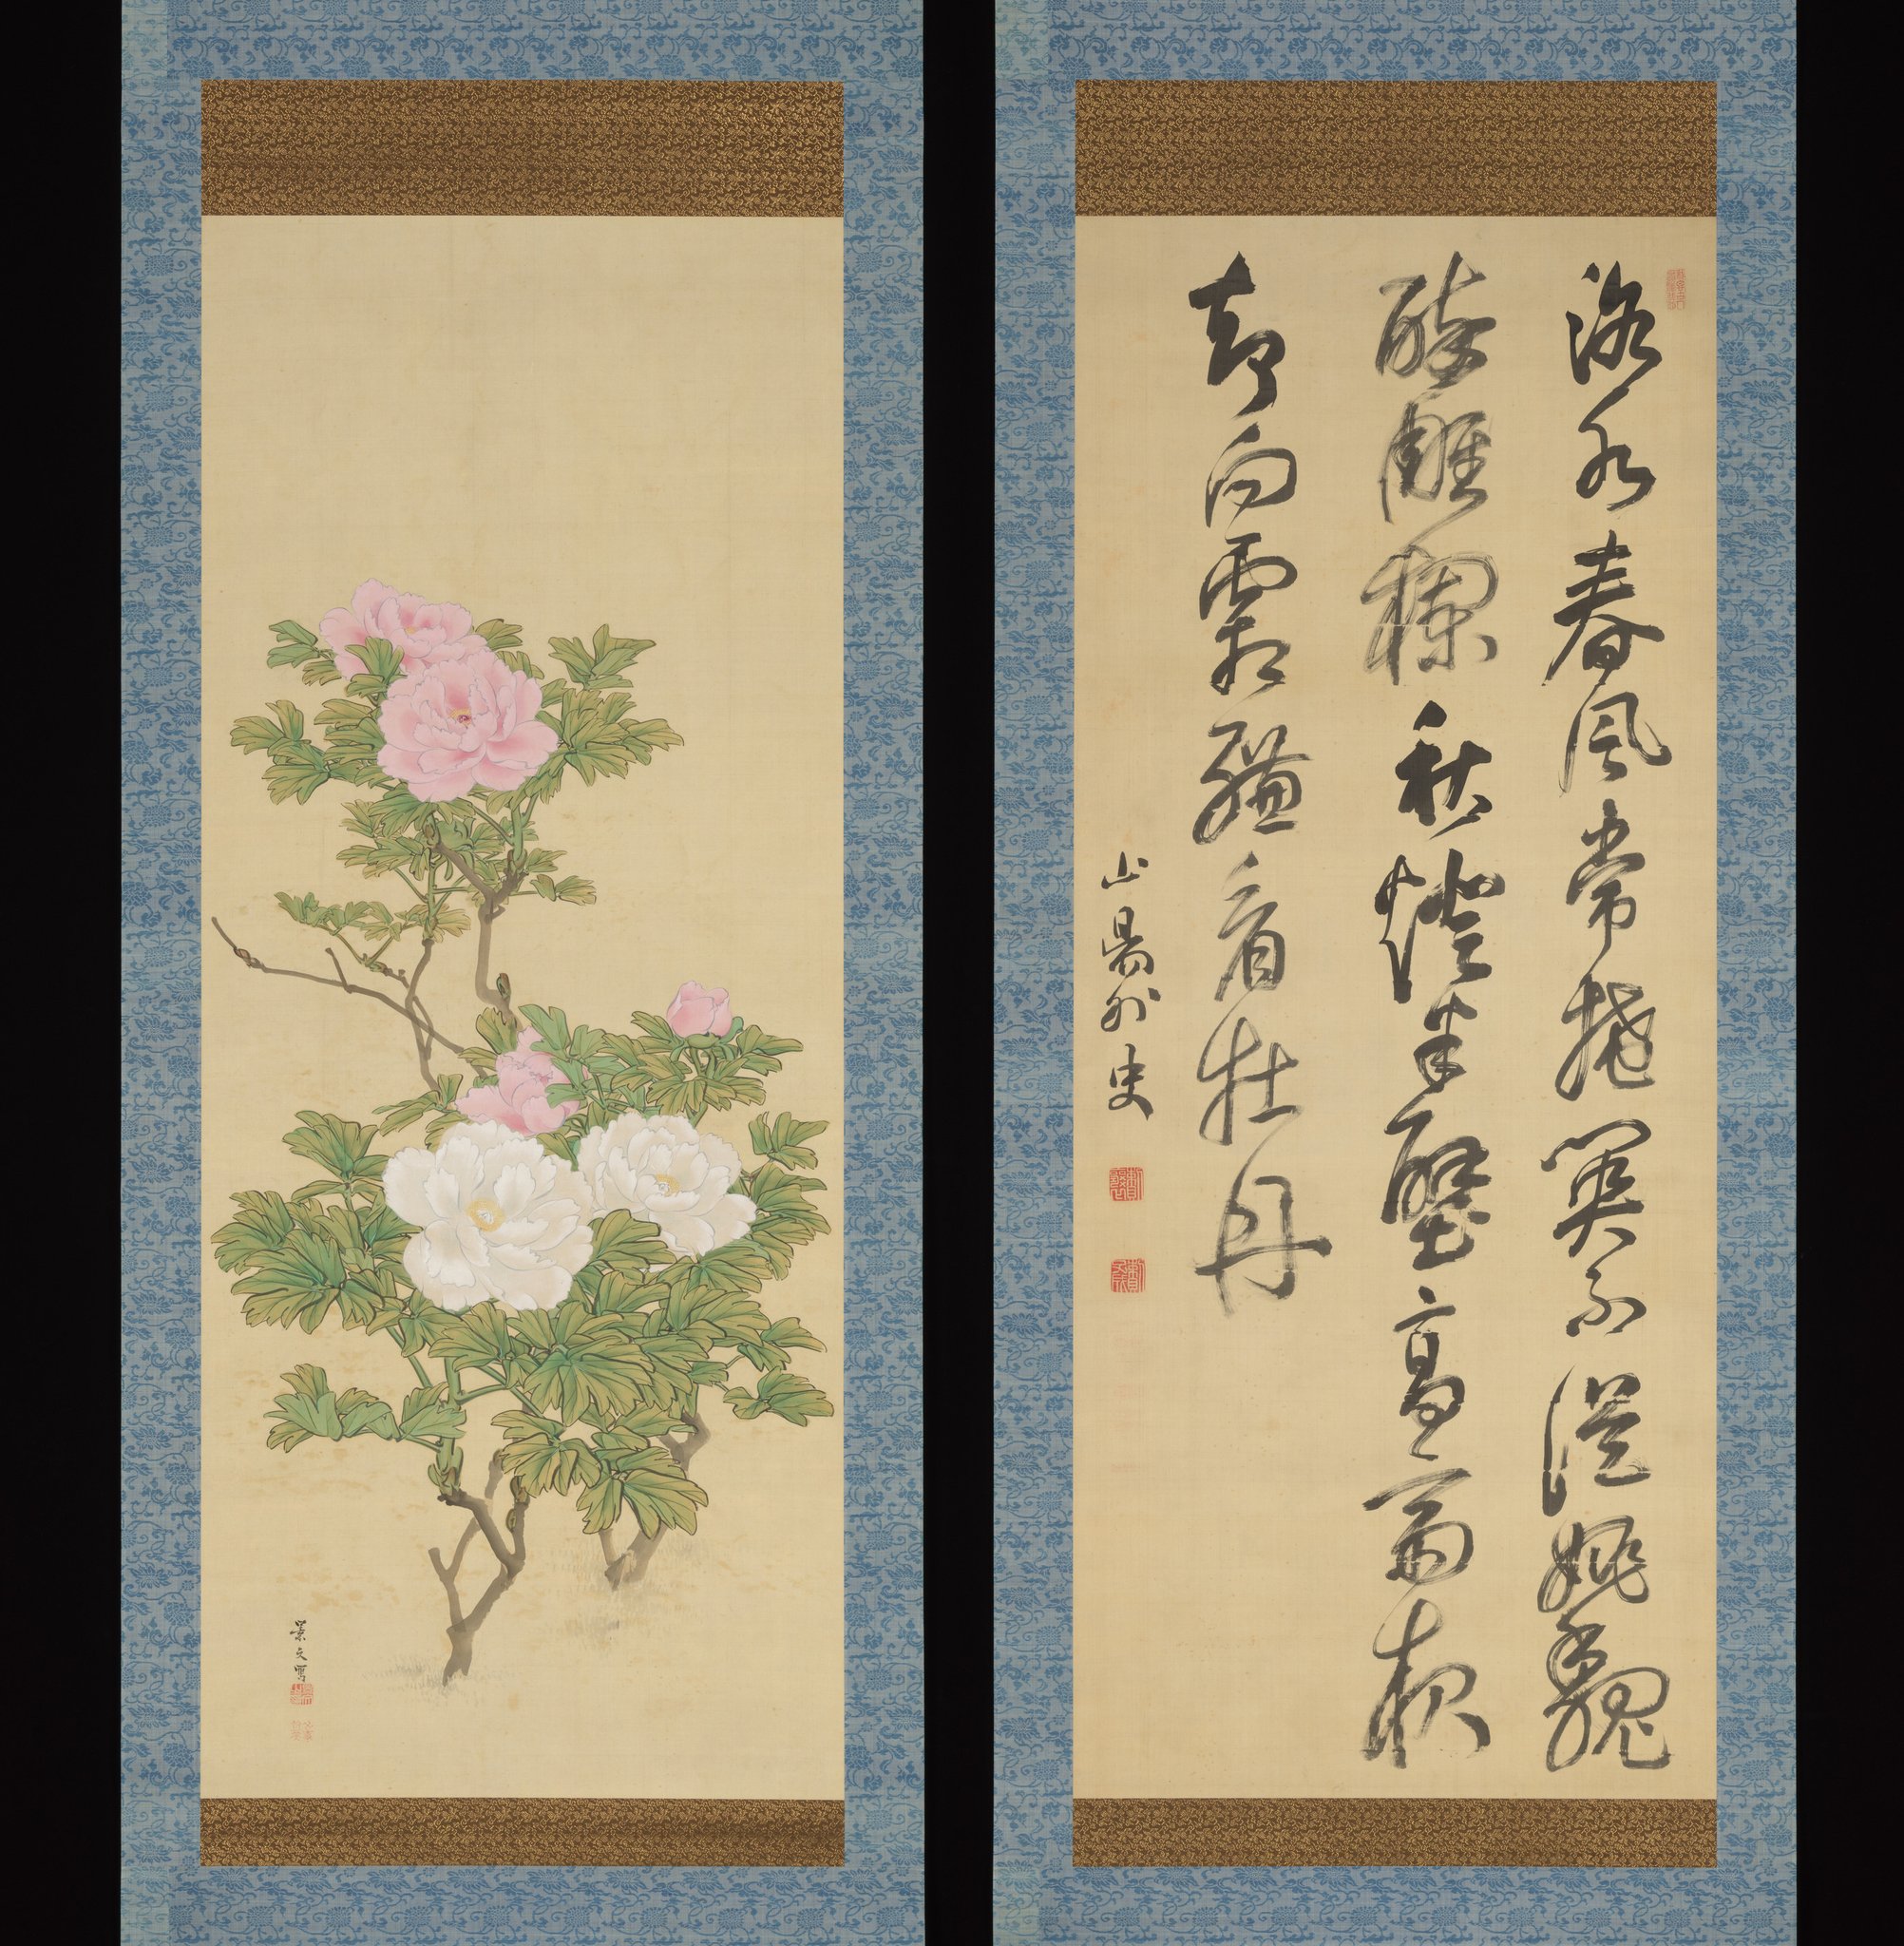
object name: hanging scroll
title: Tree Peonies and Chinese Poem on Peonies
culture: japanese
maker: matsumura keibun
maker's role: artist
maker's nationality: japanese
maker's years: 1779-1843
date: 1830-1839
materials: ink, silk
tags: peonies